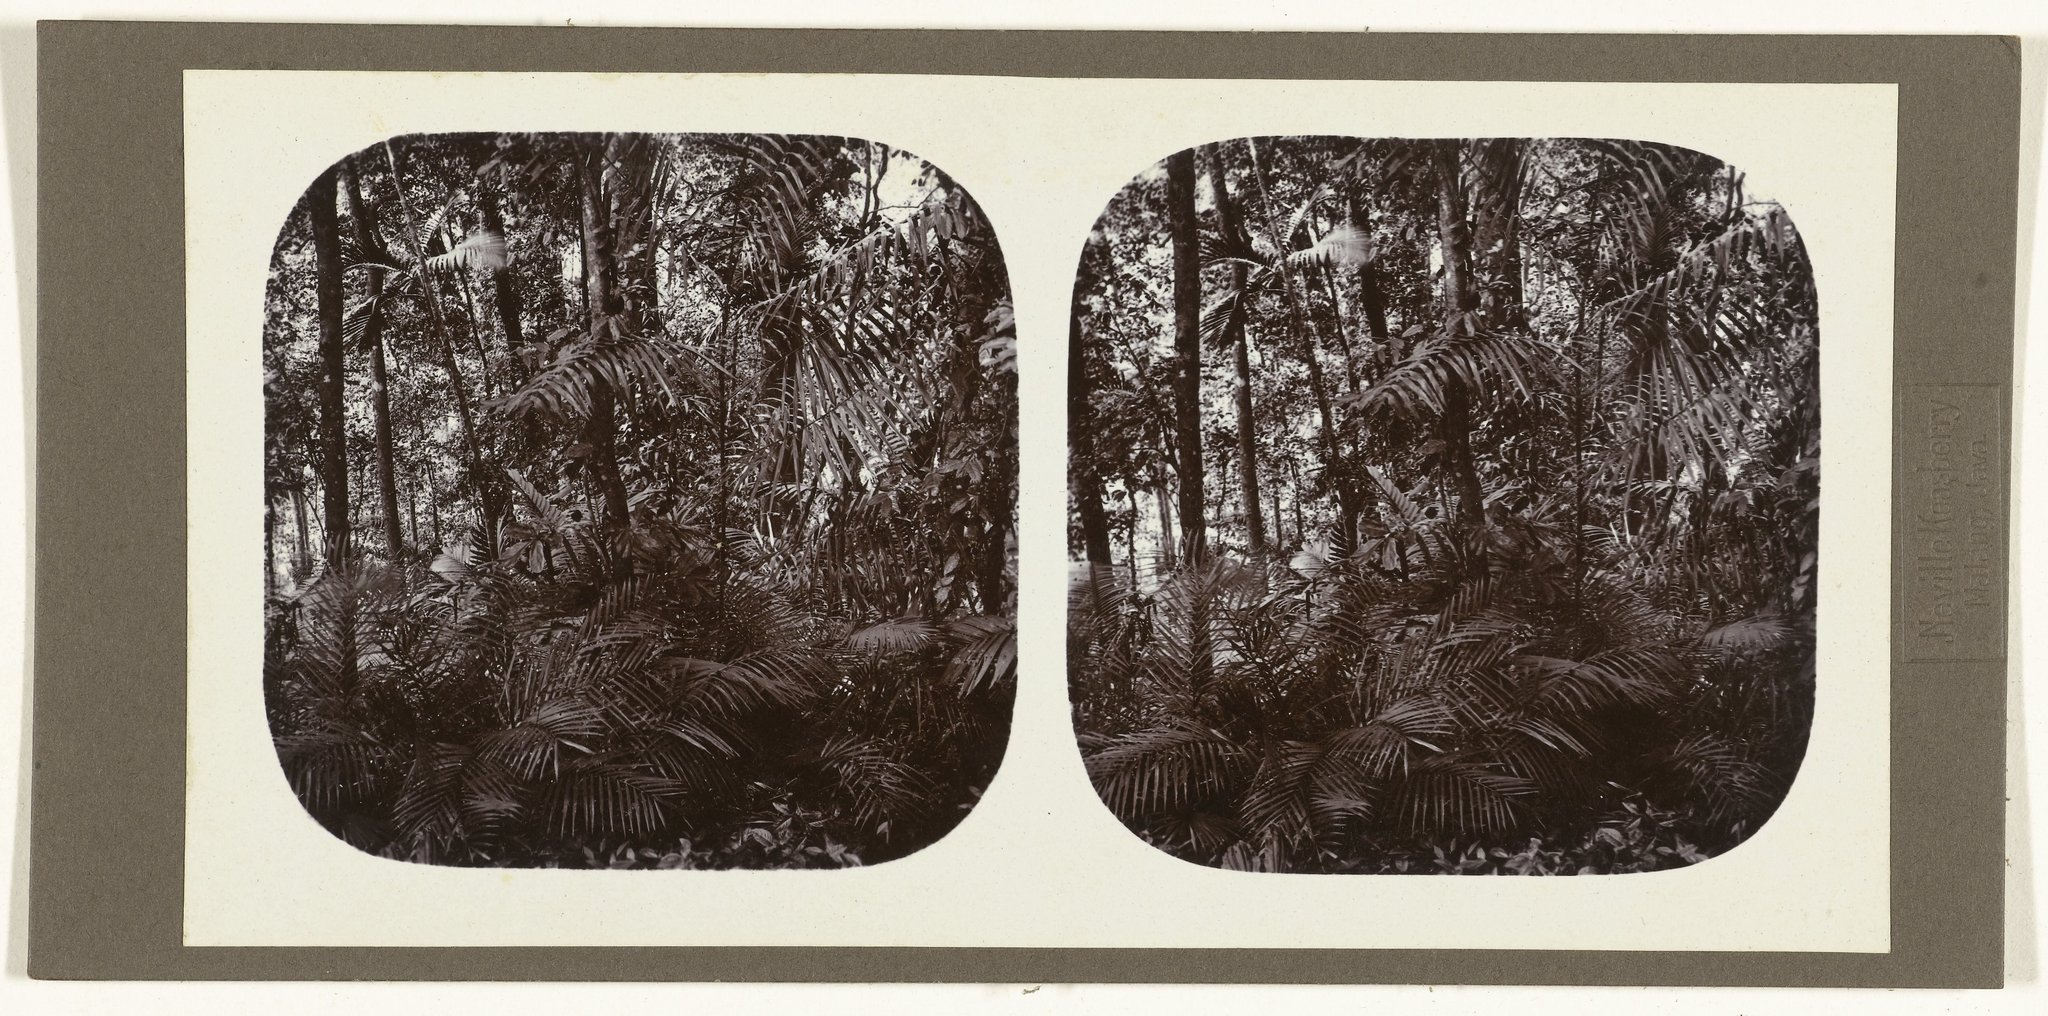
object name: stereograph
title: Bos met rotan palmen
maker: neville keasberry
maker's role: fotograaf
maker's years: 1866-1944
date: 1900-1935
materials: cardboard, paper, photographic support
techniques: albumen print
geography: malang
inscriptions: signature: ‘Neville Keasberry, Malang (Java)’, title: ‘S 1 No 8. Een Rottan bosch o/'t Idjenplateau.’